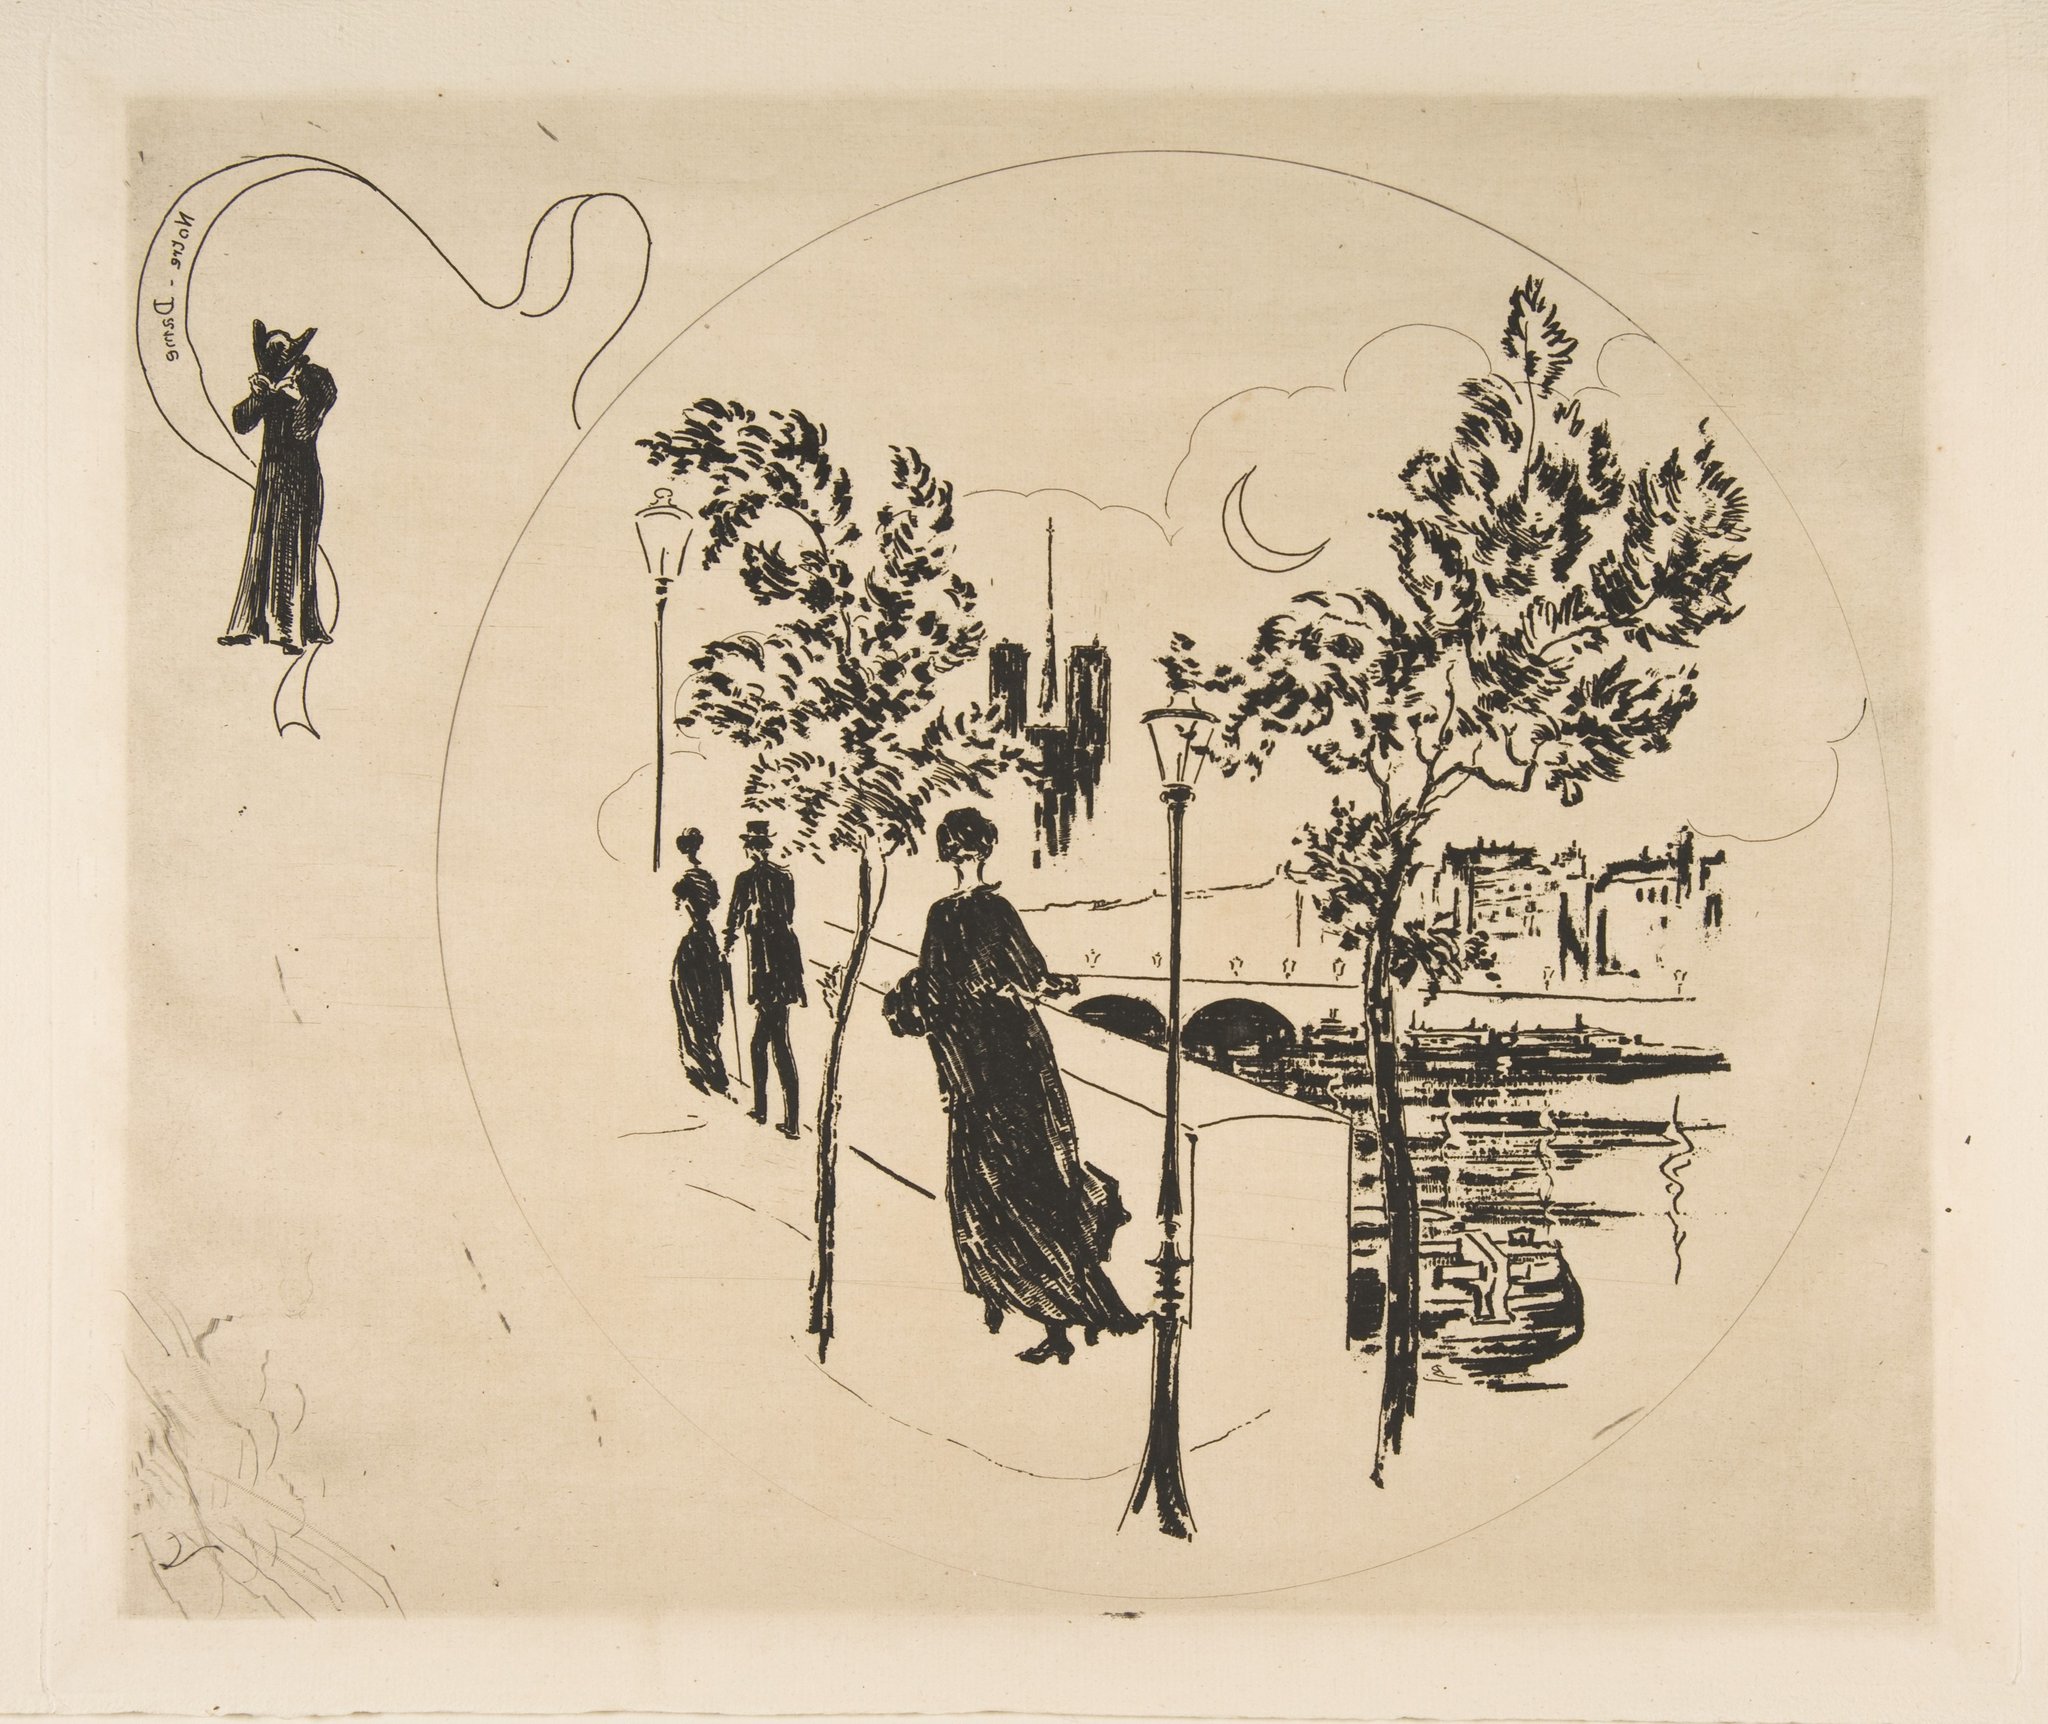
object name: print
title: Decoration for a Plate: Notre Dame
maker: félix bracquemond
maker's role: artist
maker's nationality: french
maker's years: 1833-1914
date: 1870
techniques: etching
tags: women,moon,trees,night